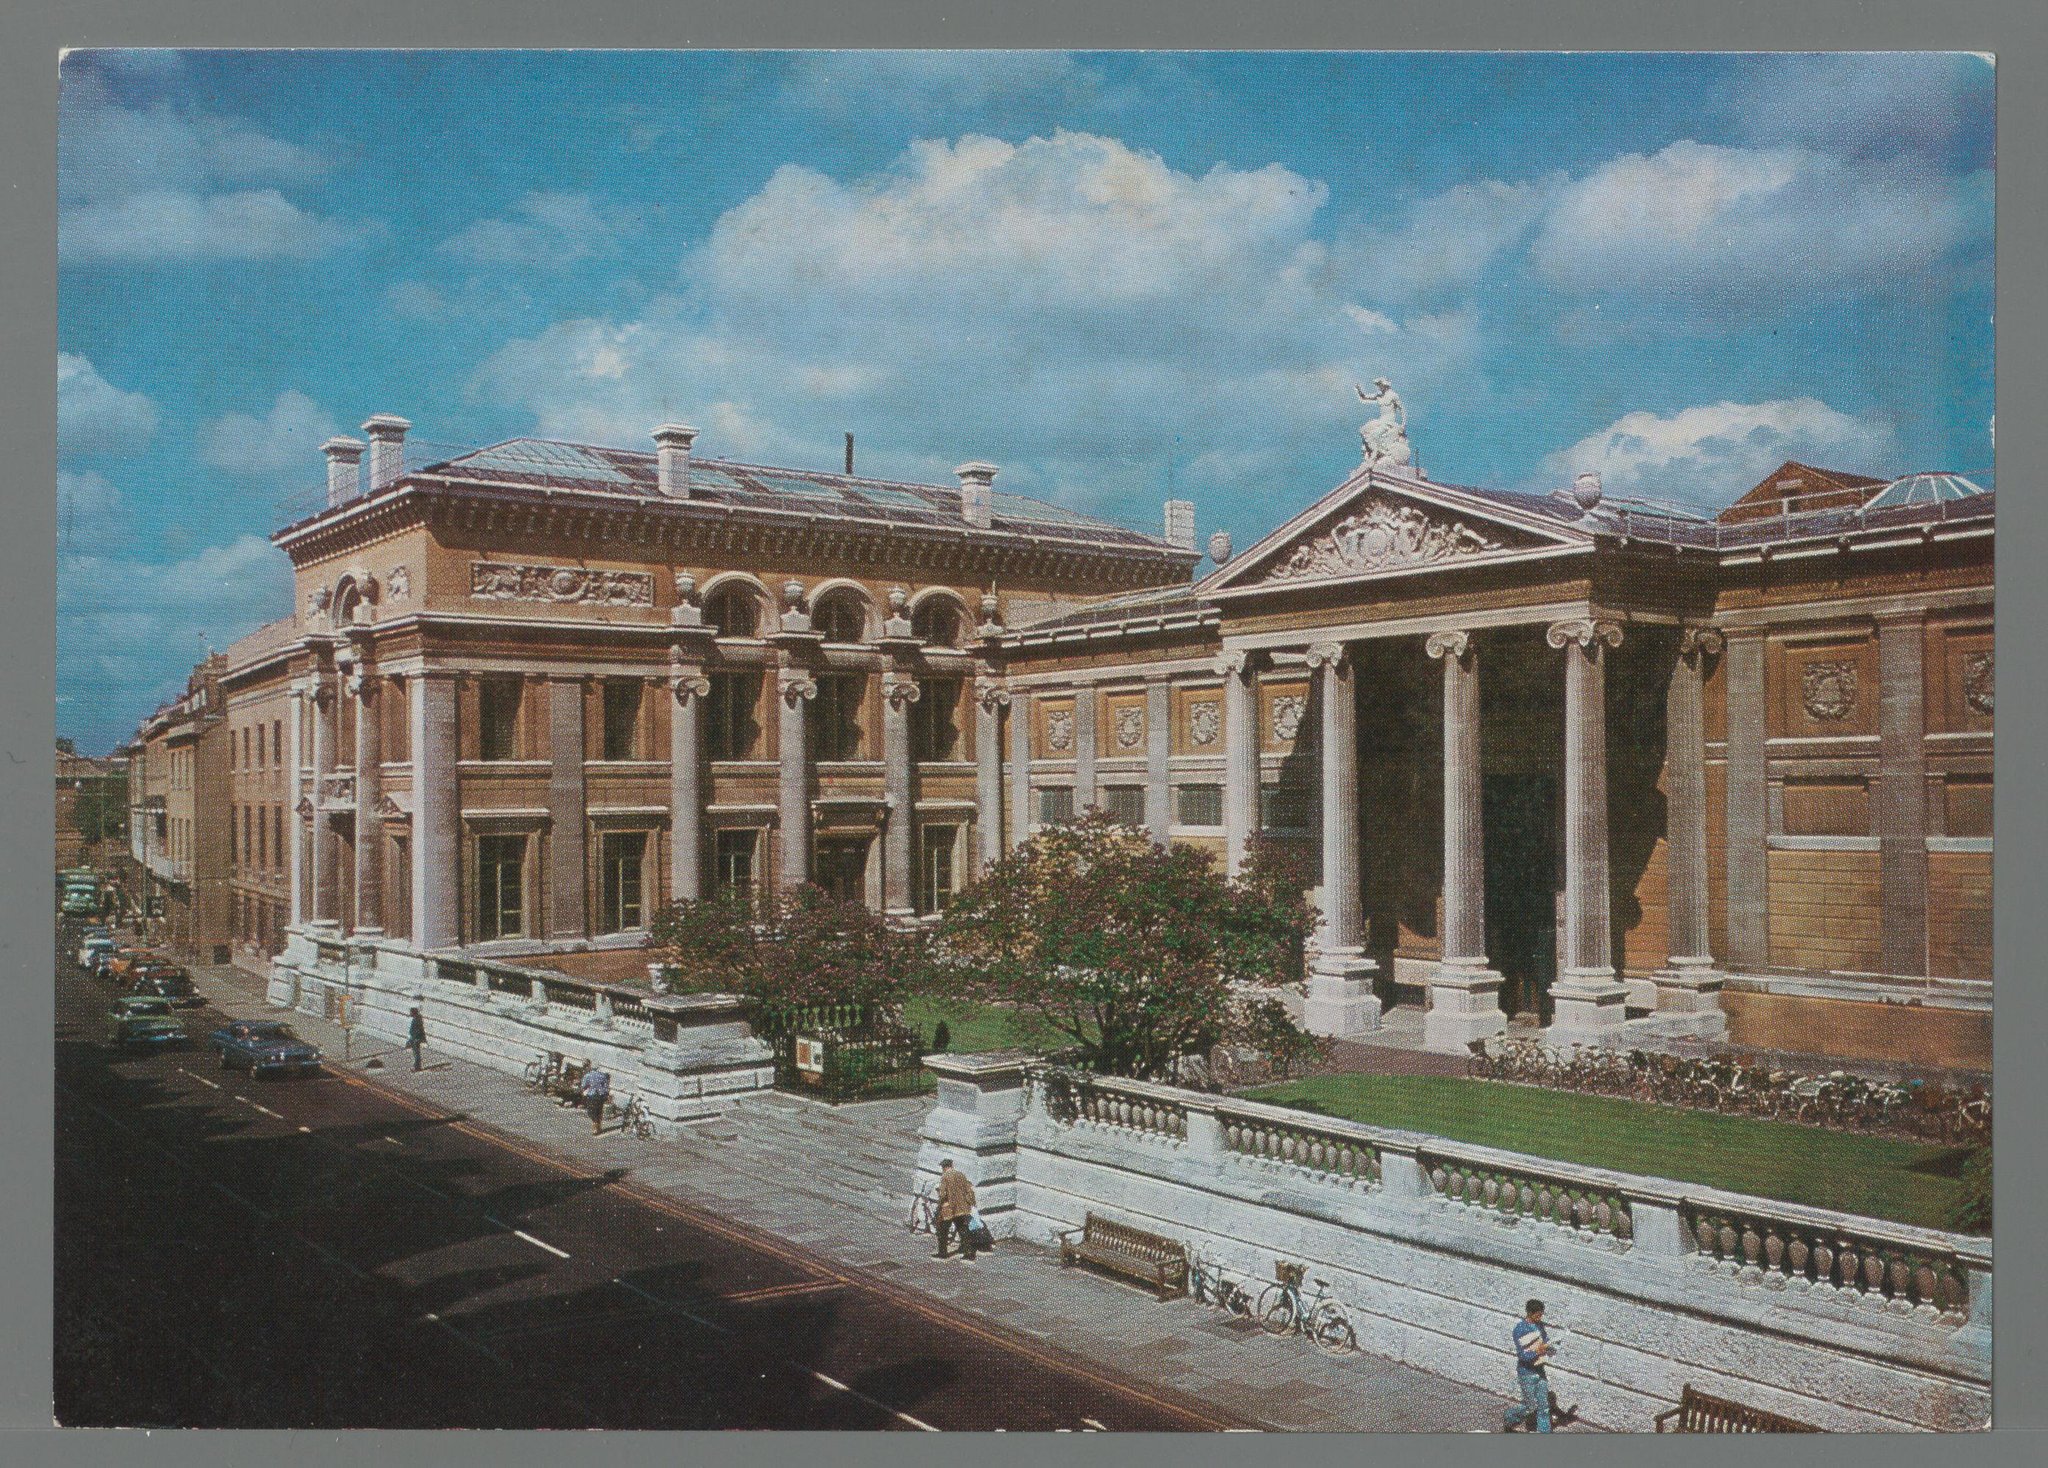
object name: ansichtkaart, prentbriefkaart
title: The Ashmolean Museum, Oxford-South front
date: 1960-1980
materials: cardboard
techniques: color autotype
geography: banbury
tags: permanent exhibition, museum